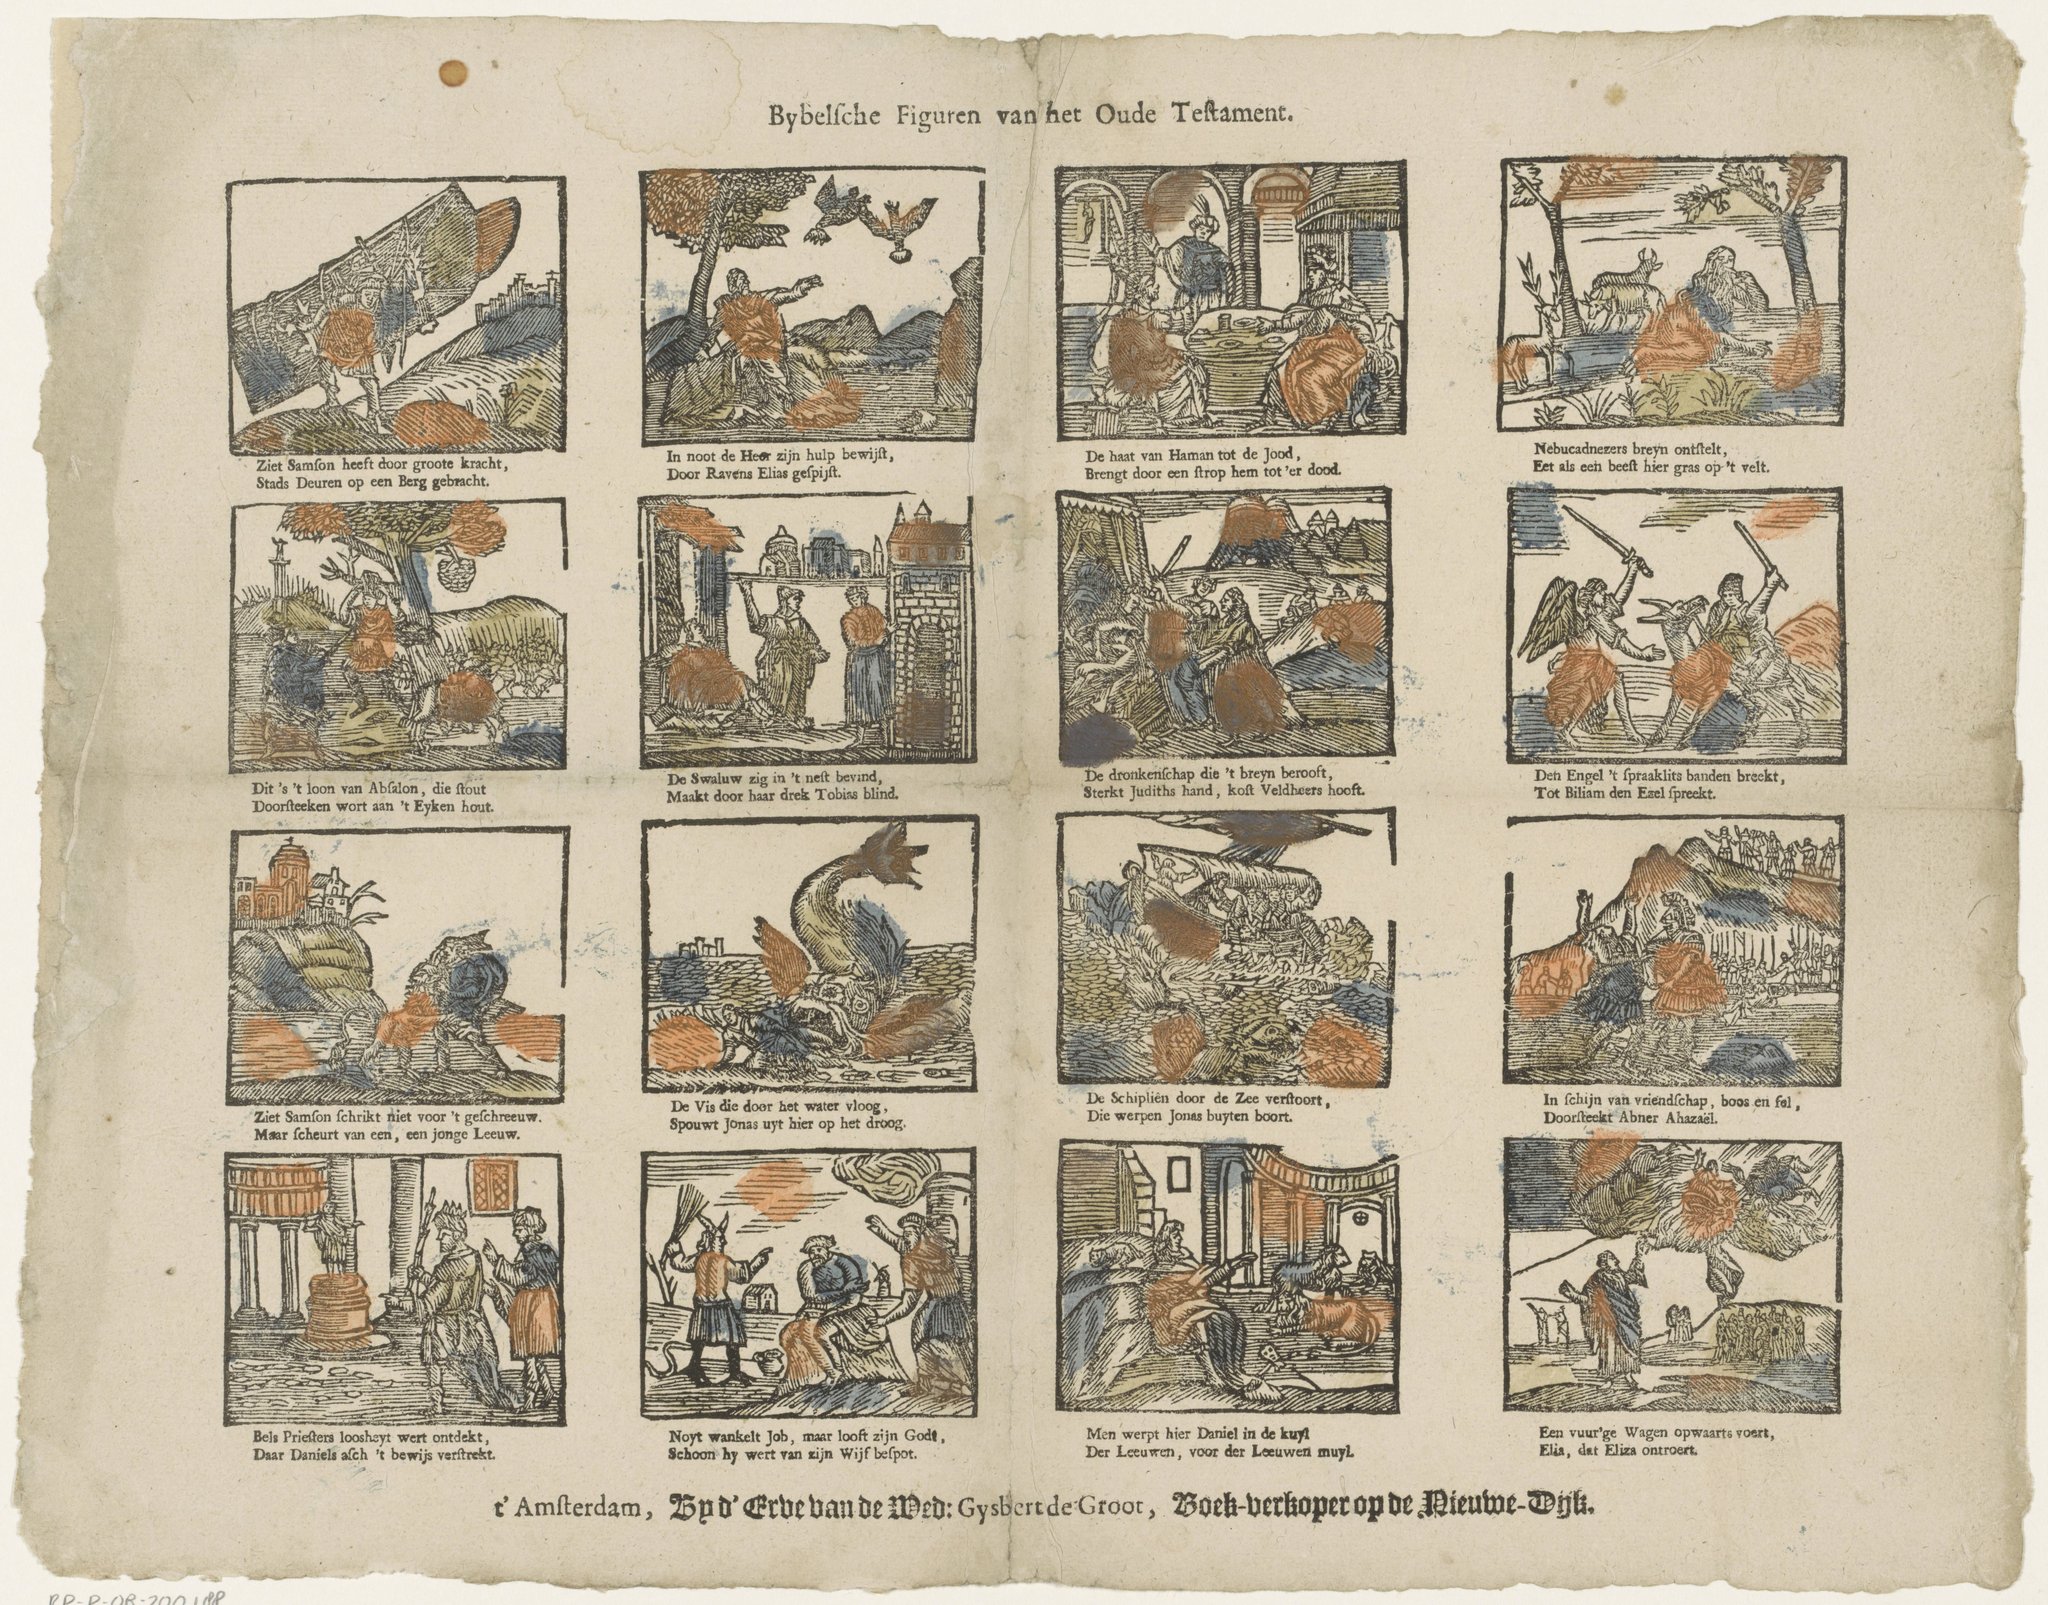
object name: popular print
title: Bijbelsche figuren van het Oude Testament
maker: Anonymous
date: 1725-1738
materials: paper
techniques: colour, letterpress printing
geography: amsterdam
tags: samson carries the doors on his shoulders to the top of a hill near hebron, a bird dropping falls in tobit's eyes, after a three-day sojourn in the belly of the monster jonah is cast on dry land; jonah may be shown nude and bald-headed, old testament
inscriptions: collector's mark: Lugt 2228, collector's mark: Lugt 2760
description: Blad met 16 voorstellingen van verhalen uit het Oude Testament, zoals Simson die de stadspoort van Gaza een bergtop op sleept, Tobit die blind wordt door de poep van een zwaluw en Jona die uit de vis wordt gespuugd. Onder elke afbeelding een tweeregelig vers.